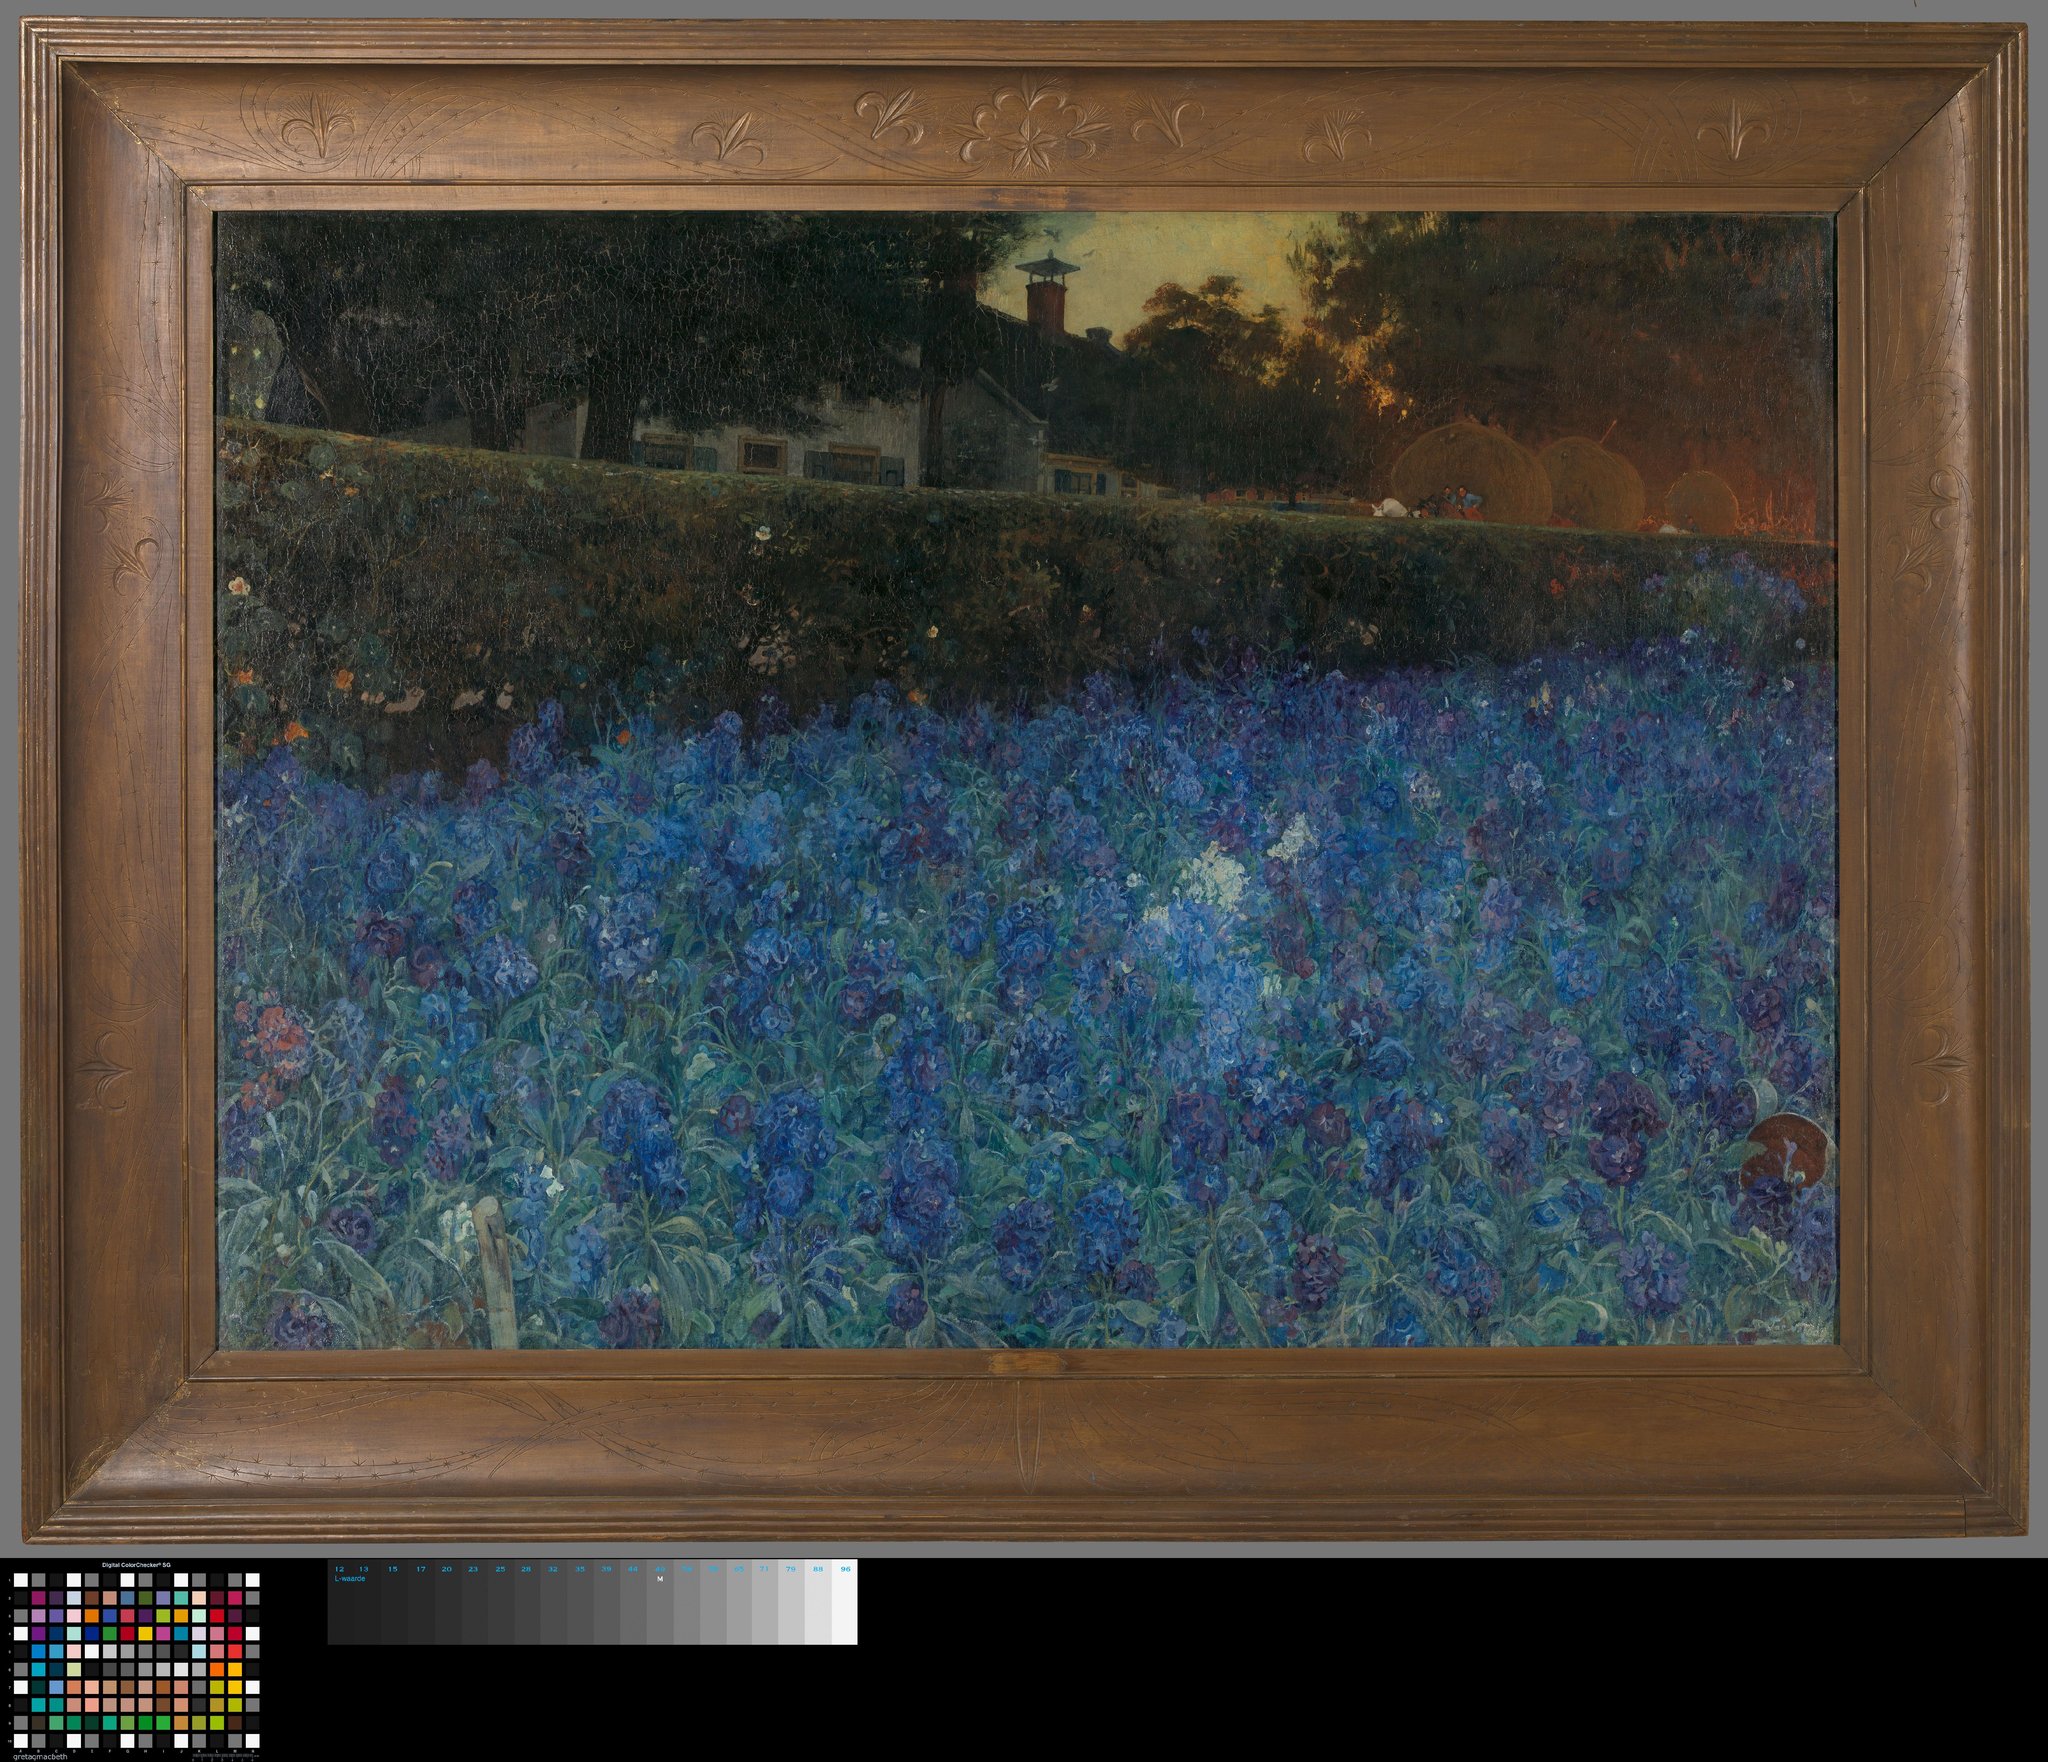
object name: painting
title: July (‘Summer Luxuriance’)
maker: jac van looij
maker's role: draughtsman, painter, print maker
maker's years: 1855-1930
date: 1890-1910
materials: canvas, oil, paint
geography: soesterberg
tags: flower culture, hay-wagon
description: It seems as if Van Looy has lavishly strewn blue flowers all over this large canvas. Looking a bit longer, however, one notices the artist’s house in Soest and the hay wagons behind the tall hedge, and in the right foreground an overturned pot among the flowers. The painter was clearly inspired by the landscapes of Van Gogh, but his representation of nature and the fall of light are more realistic.